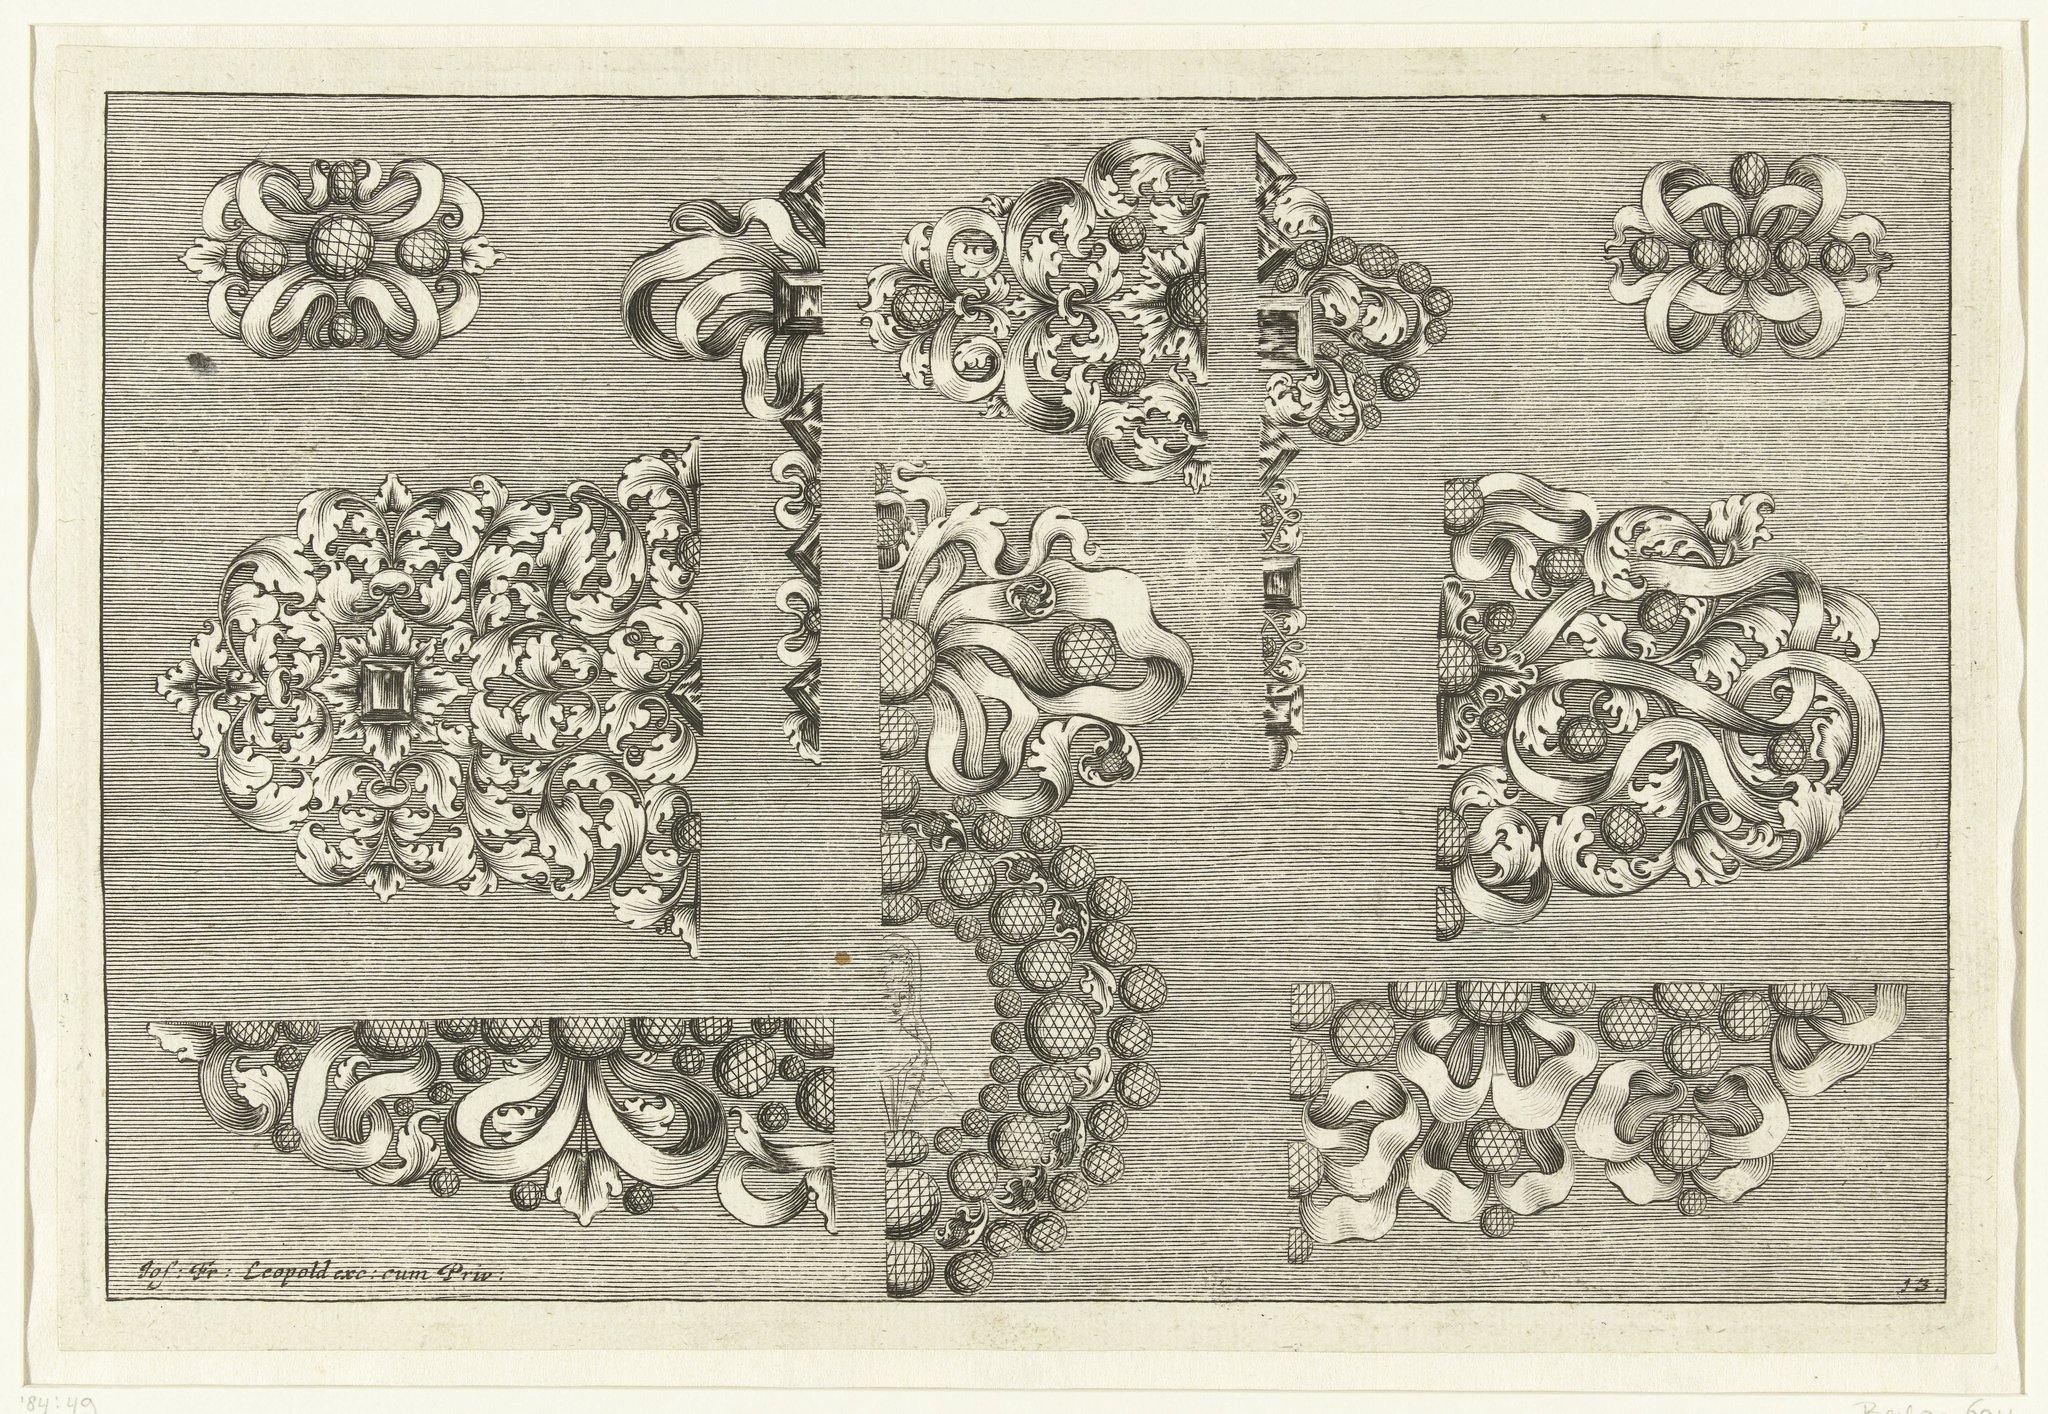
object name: ornament print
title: Elf ontwerpen voor juwelen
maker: joseph friedrich leopold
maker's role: print maker, publisher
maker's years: 1668-1726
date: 1695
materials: paper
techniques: engraving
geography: germany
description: De meeste ontwerpen zijn slechts voor de helft weergegeven. Blad 13 uit serie van 17 bladen.